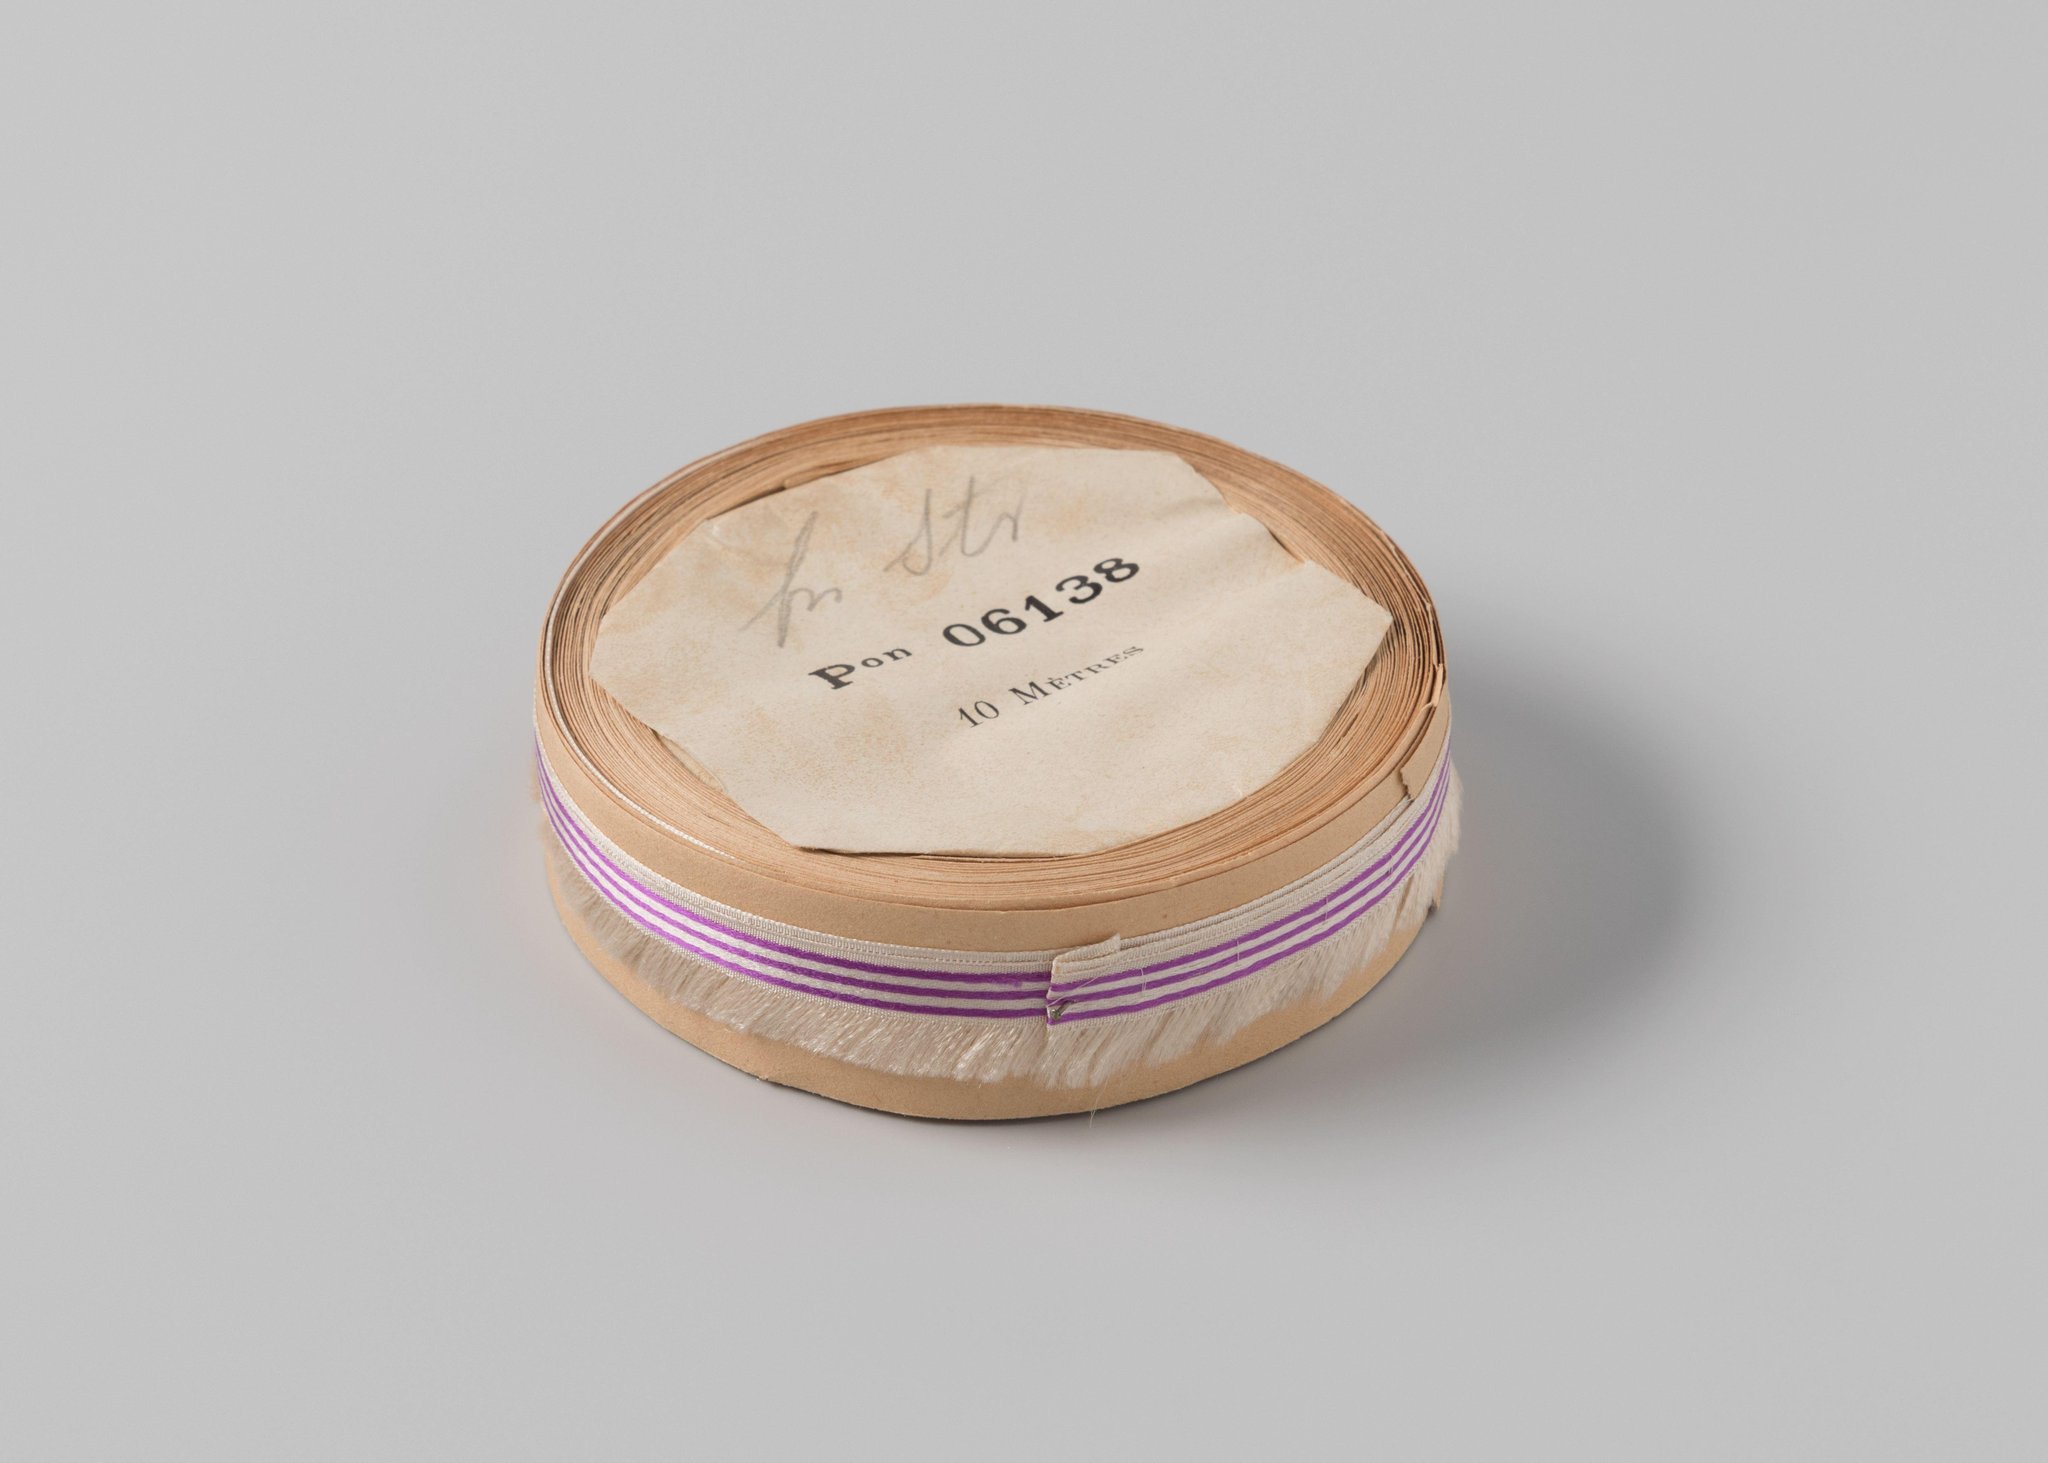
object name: braid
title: Rol met wit lint met één gerafelde zijde en drie paarse horizontale strepen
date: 1930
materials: cardboard, paper, textile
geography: nijmegen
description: Rol met wit lint met één gerafelde zijde en drie paarse horizontale strepen.